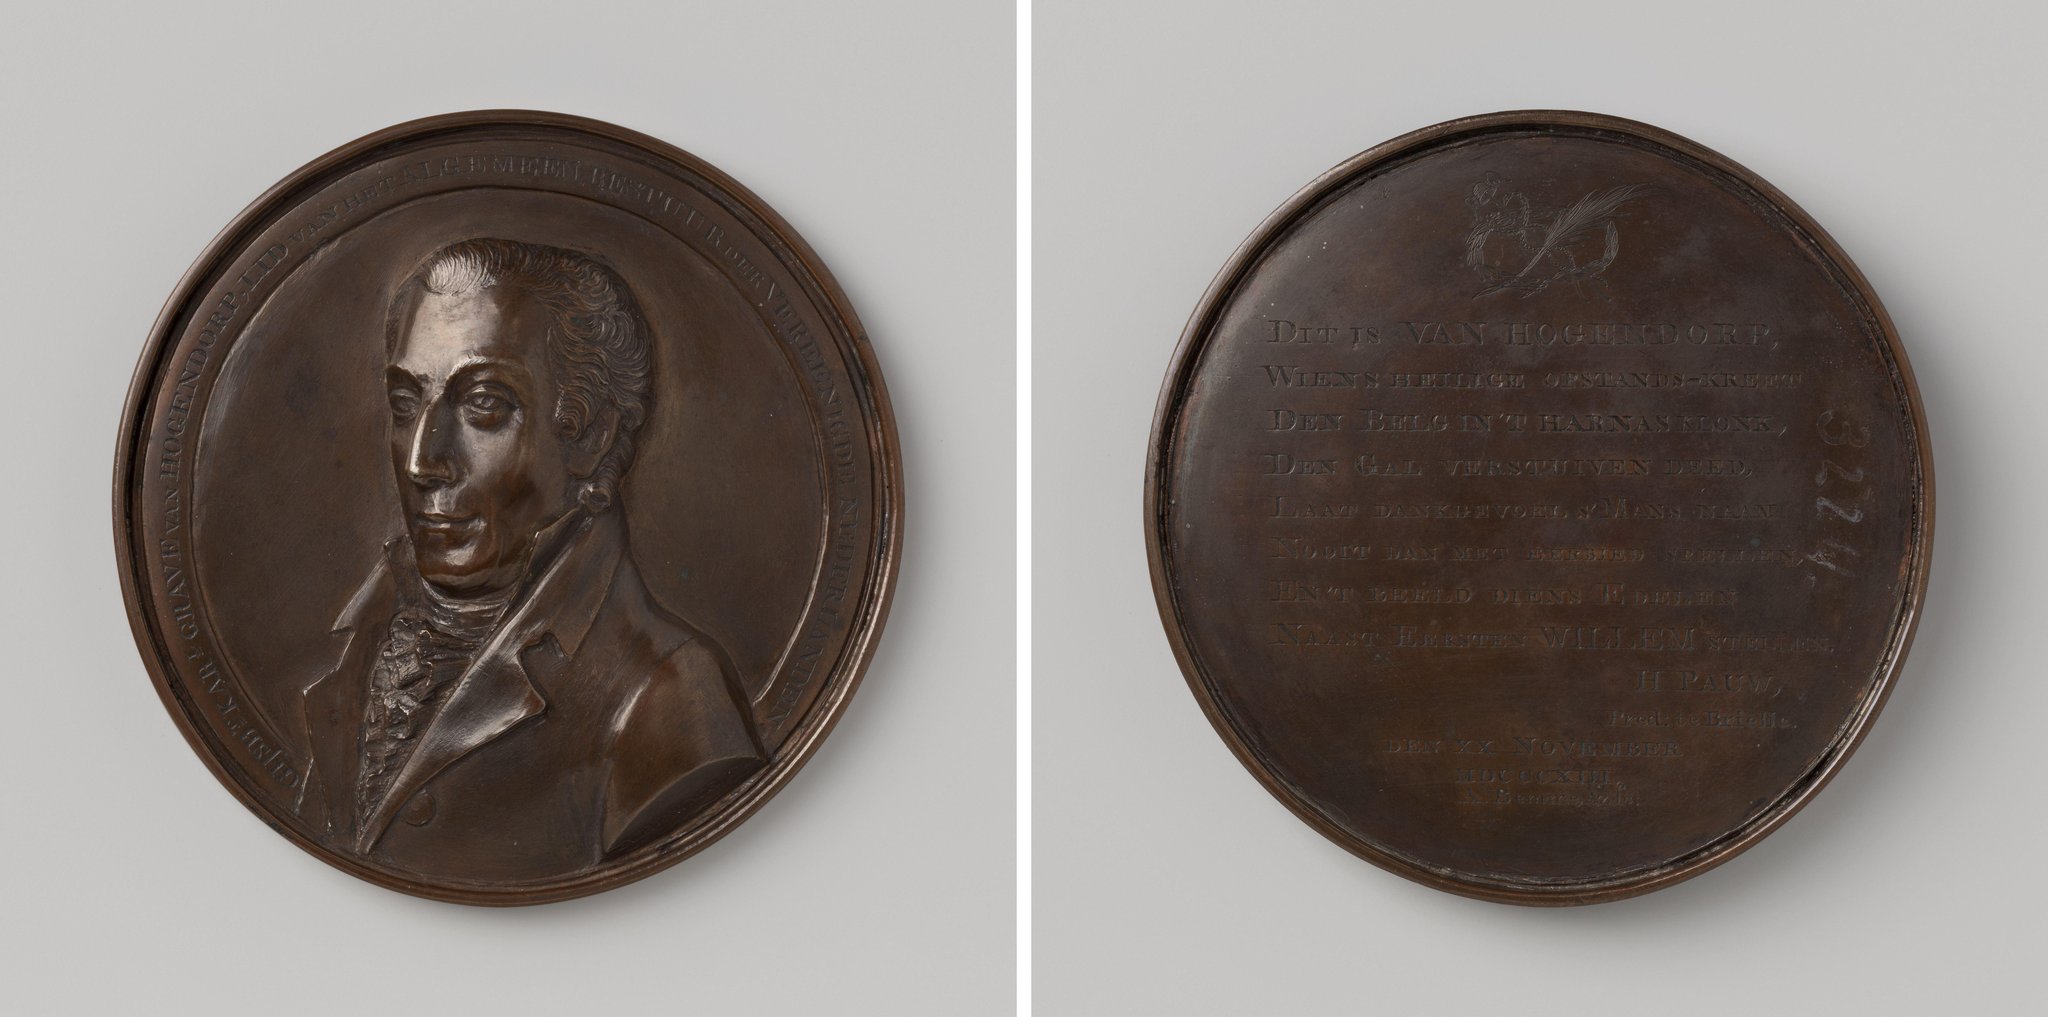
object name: history medal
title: Gijsbert Karel van Hogendorp, wegens zijn aandeel in de bevrijding van Nederland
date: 1823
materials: copper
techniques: casting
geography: rotterdam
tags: rotterdam, the hague, gijsbert karel graaf van hogendorp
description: Gijsbert Karel van Hogendorp, wegens zijn aandeel in de bevrijding van Nederland en 10 jaar Koninkrijk in 1823. Koperen penning. Voorzijde: borststuk man binnen omschrift. Keerzijde: opschrift onder gekruiste palmtak en Mercuriusstaf in een lauwerkrans. Uniek exemplaar.